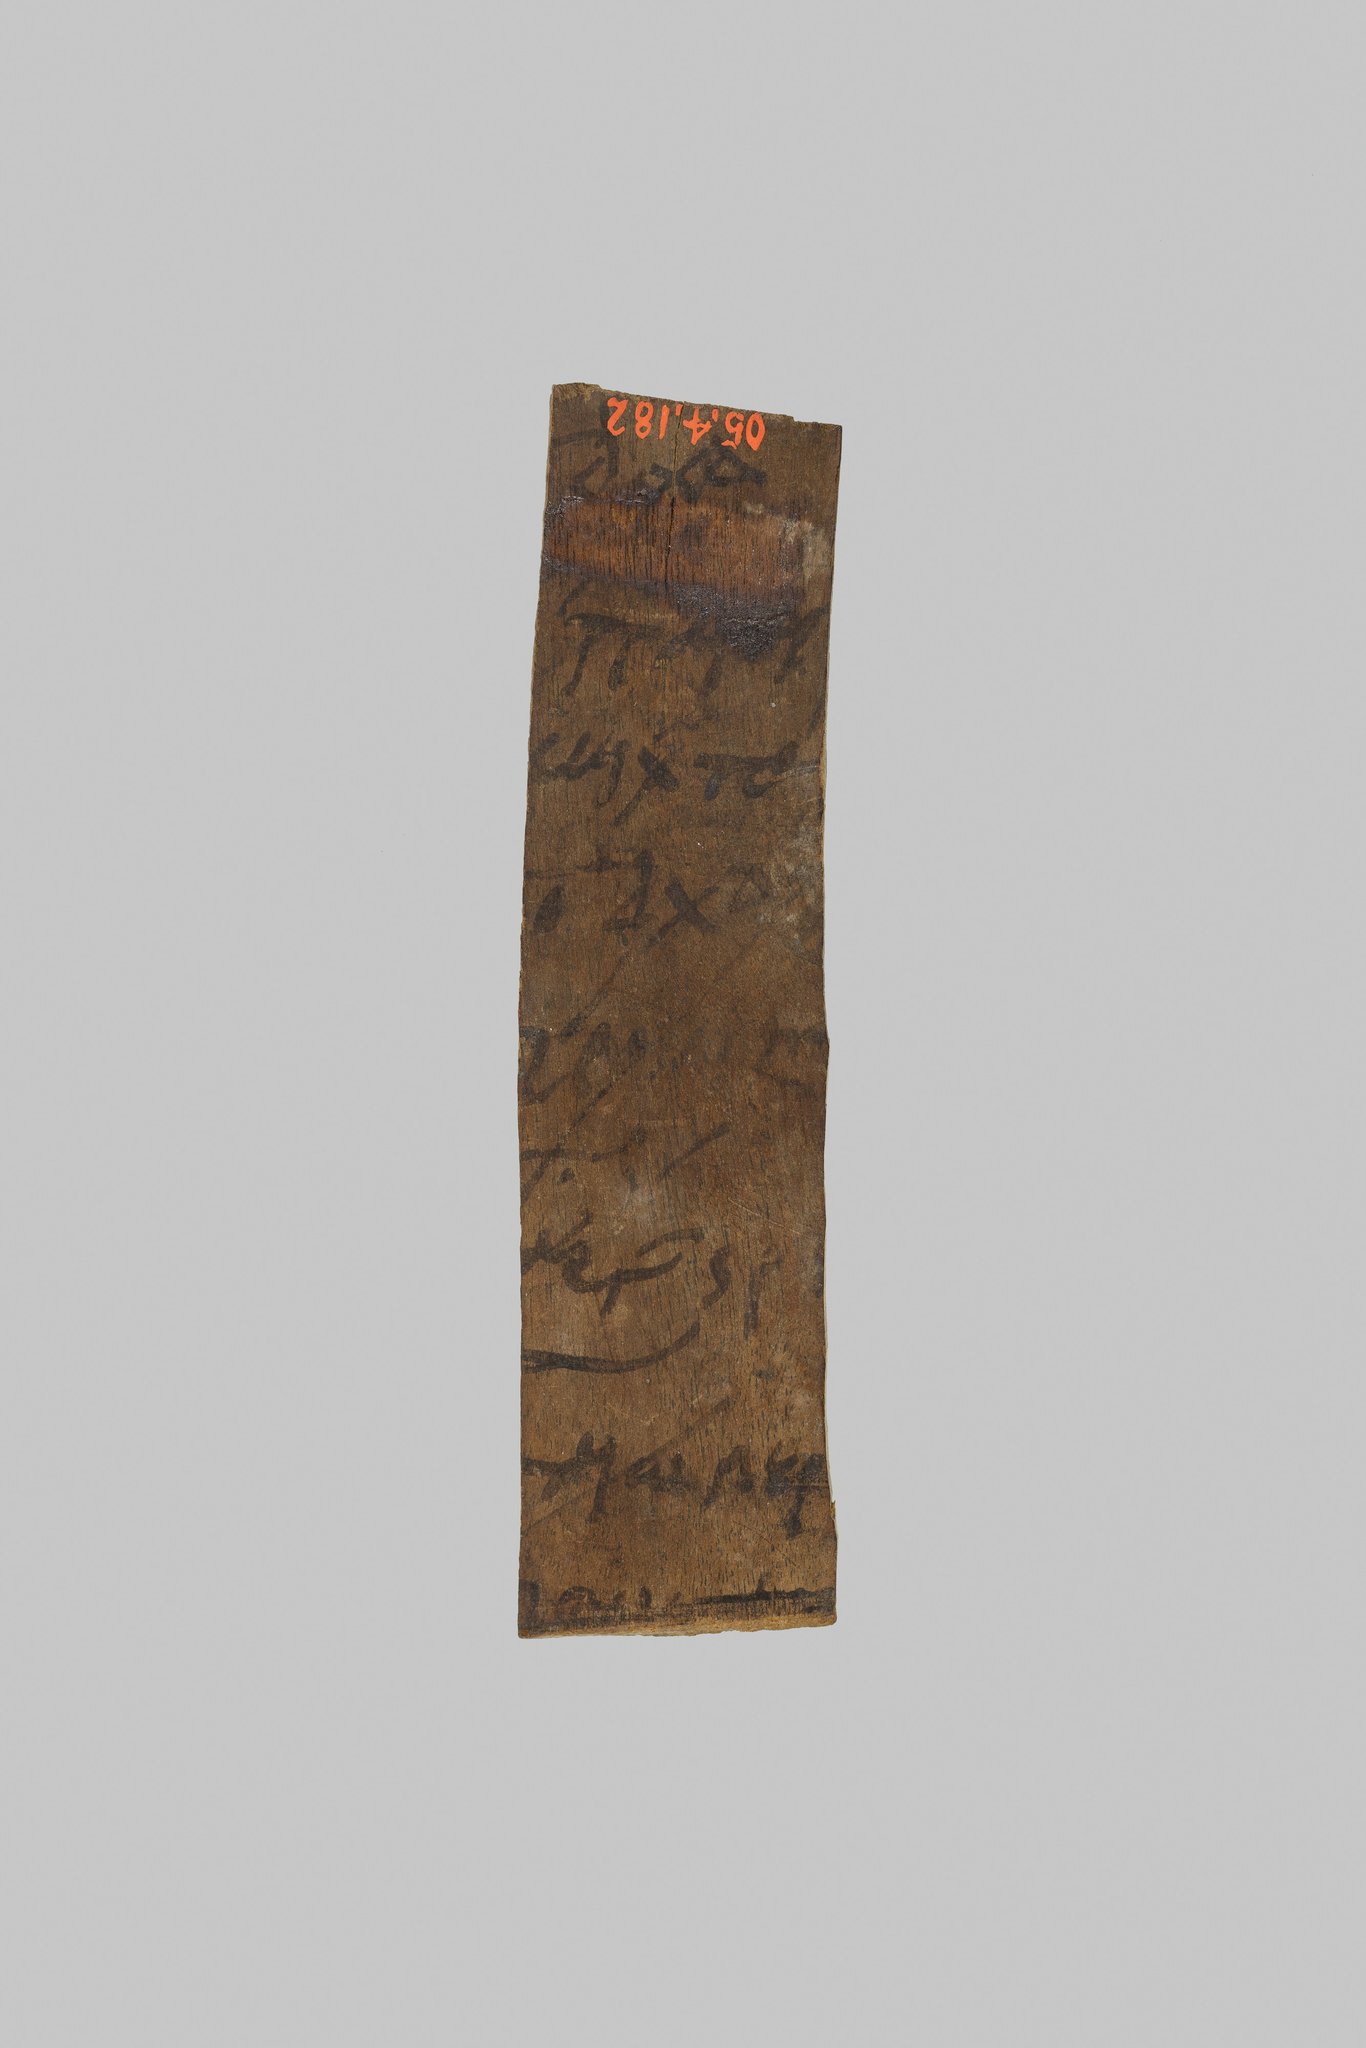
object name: mummy label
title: Fragment of a mummy label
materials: ink, wood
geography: egypt